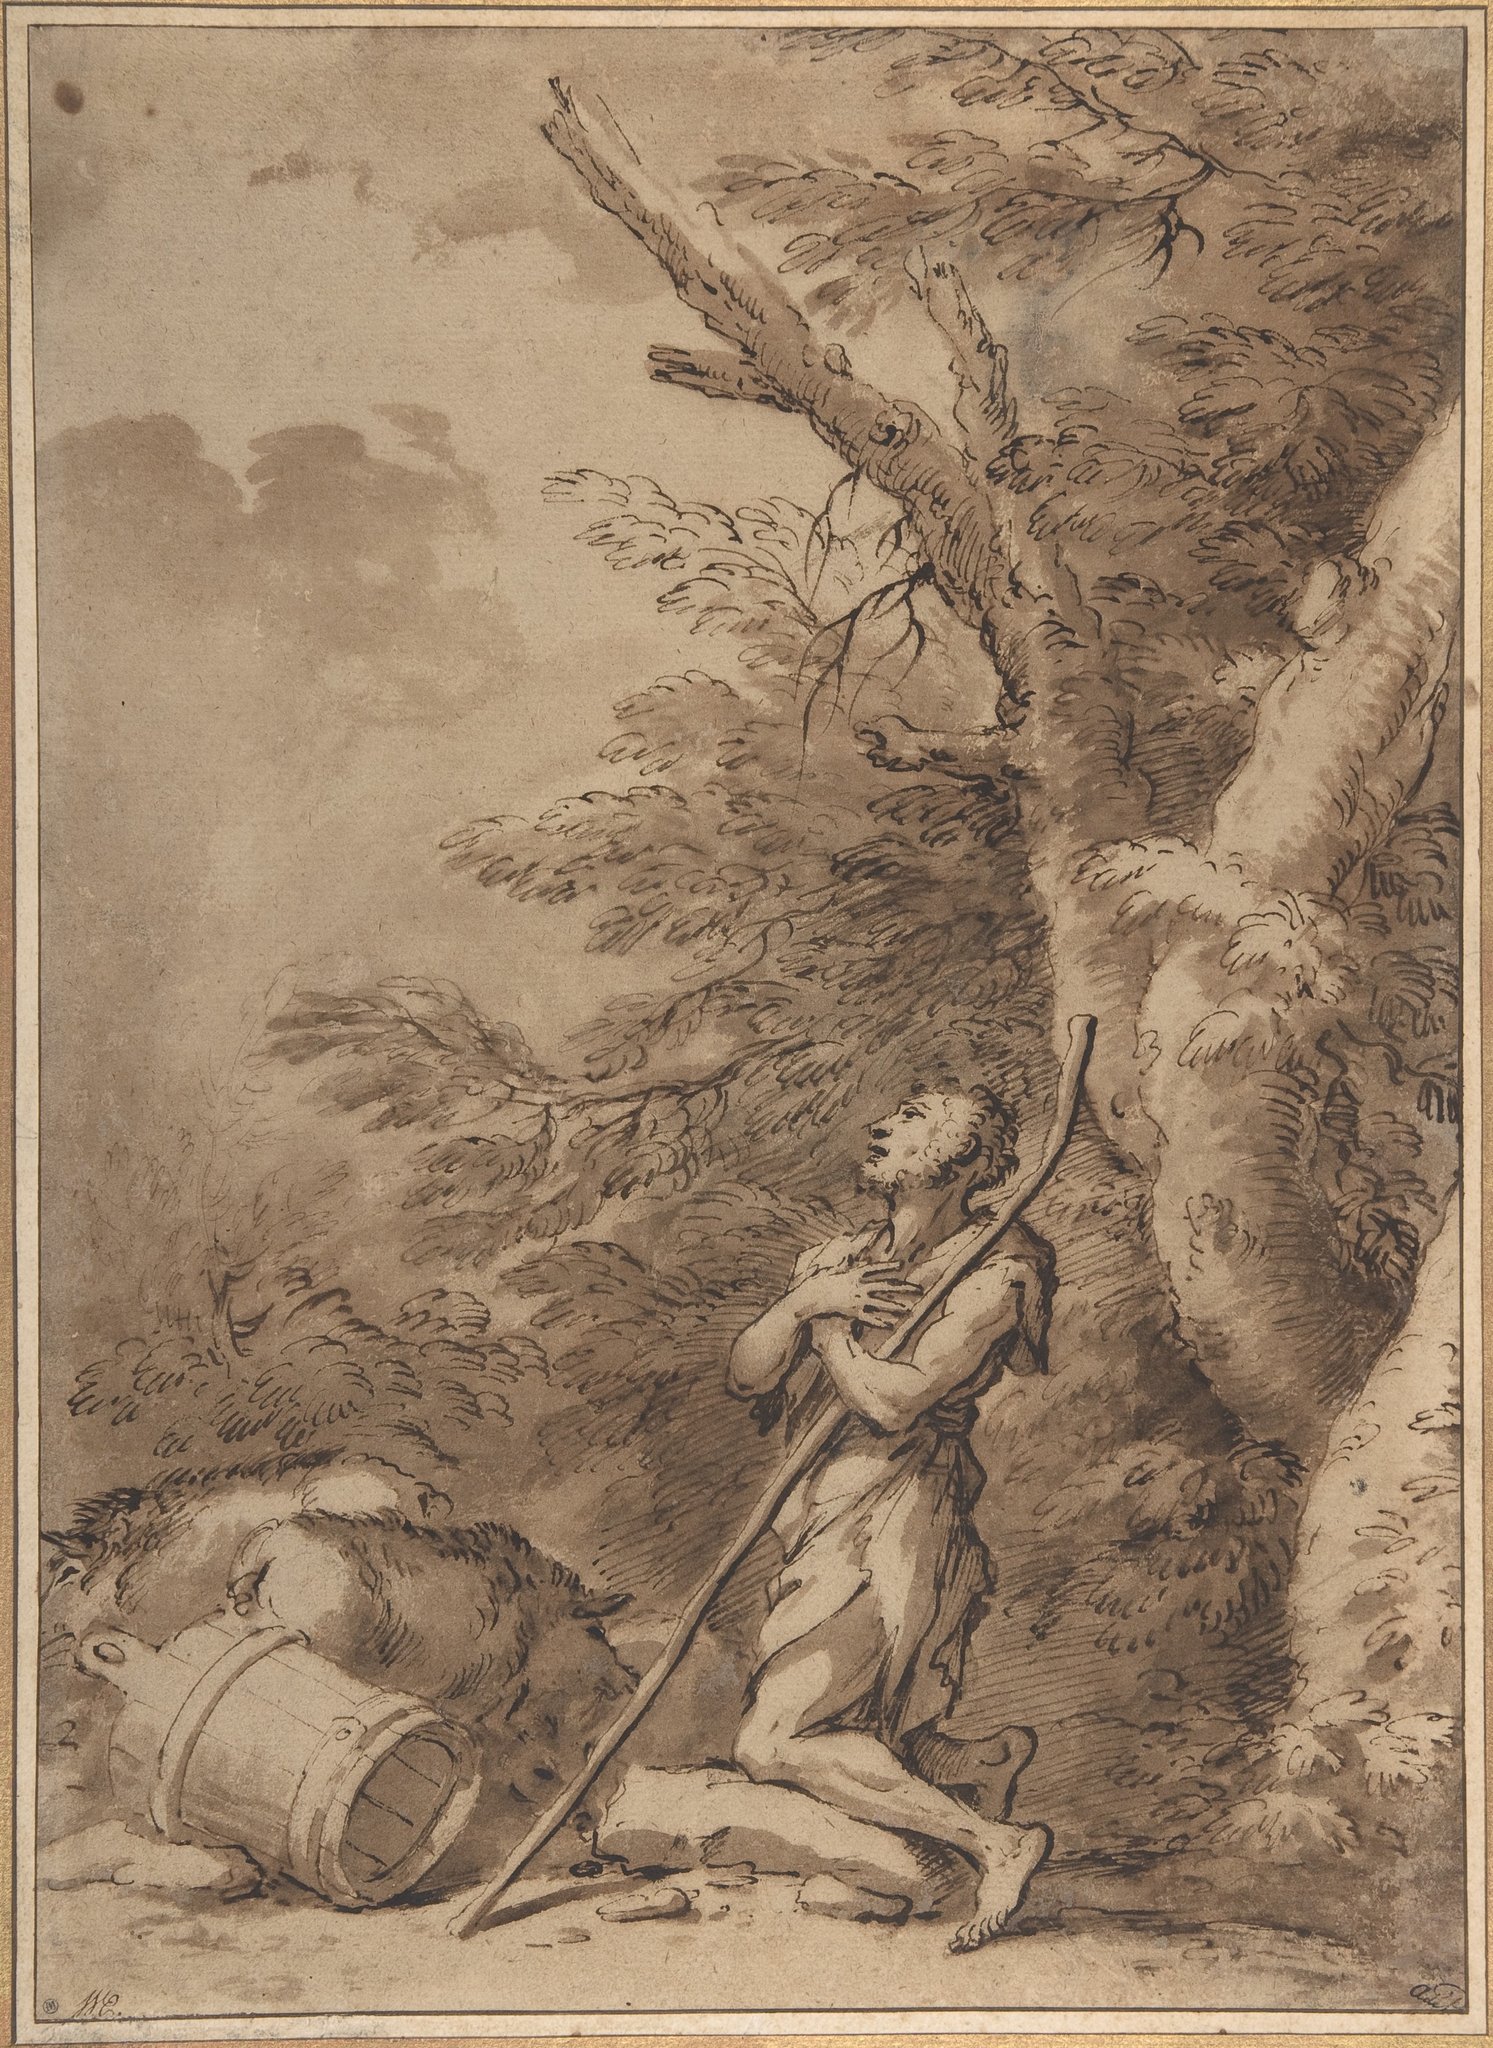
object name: drawing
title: The Prodigal Son Kneeling Repentant among Swine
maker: salvator rosa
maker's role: artist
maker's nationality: italian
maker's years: 1615-1673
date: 1615-1673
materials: ink, paper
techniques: pen, wash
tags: men,pigs